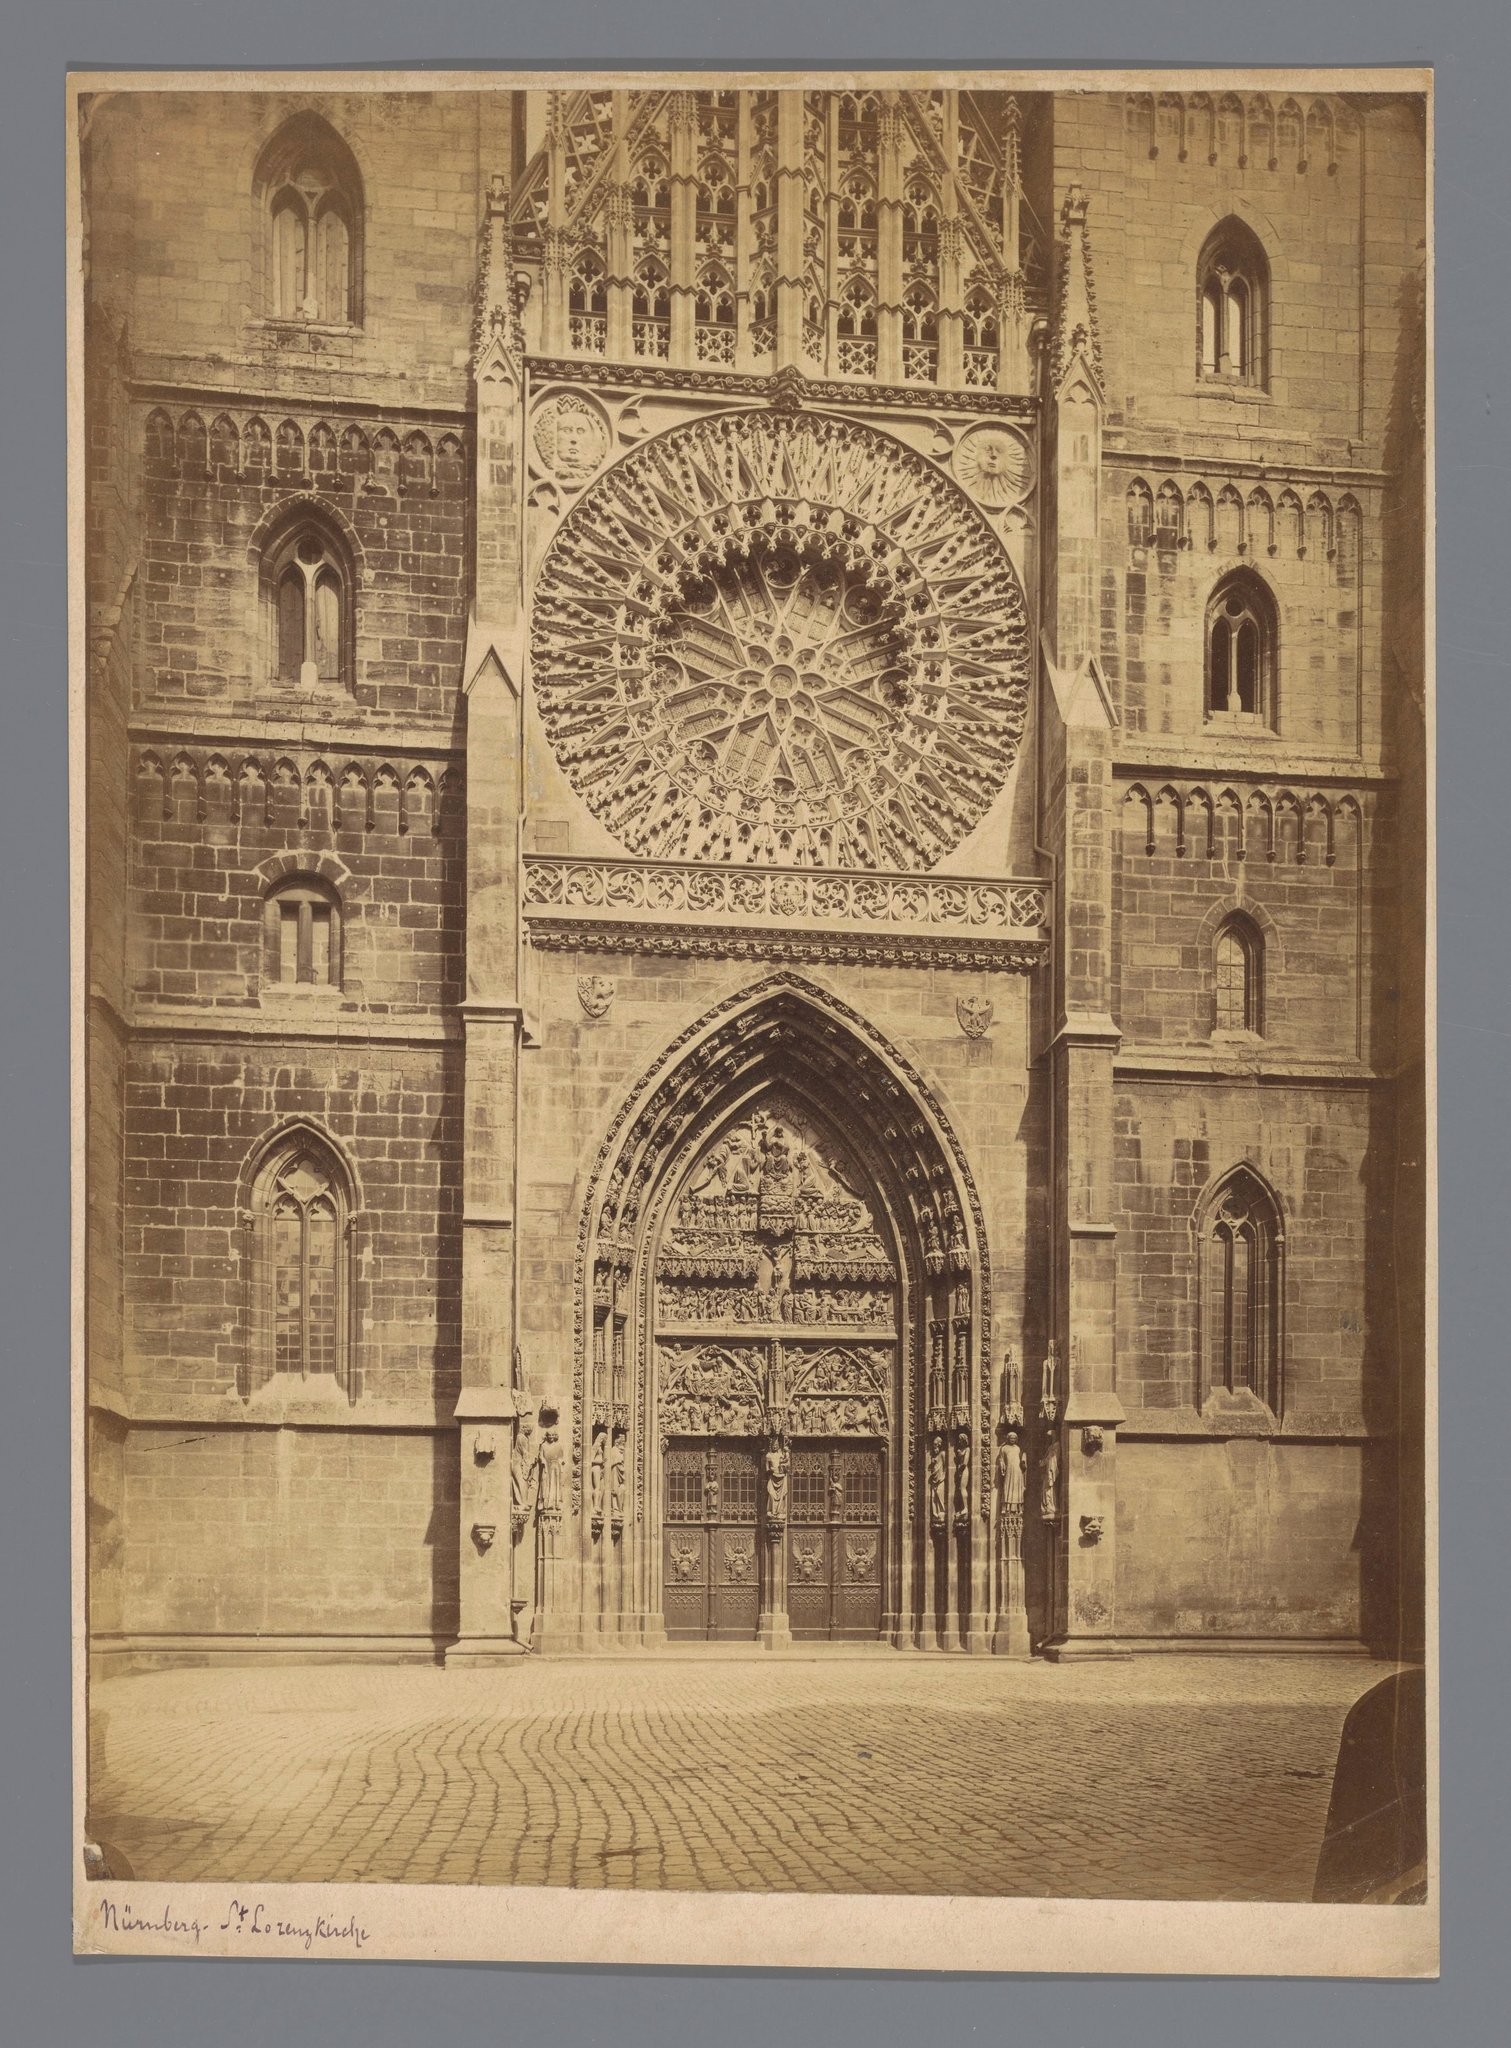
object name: photograph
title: Nürnberg. St. Lorenzkirche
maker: Anonymous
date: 1860-1890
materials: cardboard, paper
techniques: albumen print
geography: nuremberg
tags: parts of church exterior and annexes: west façade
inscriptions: inscription: ‘Nürnberg. St. Lorenzkirche’